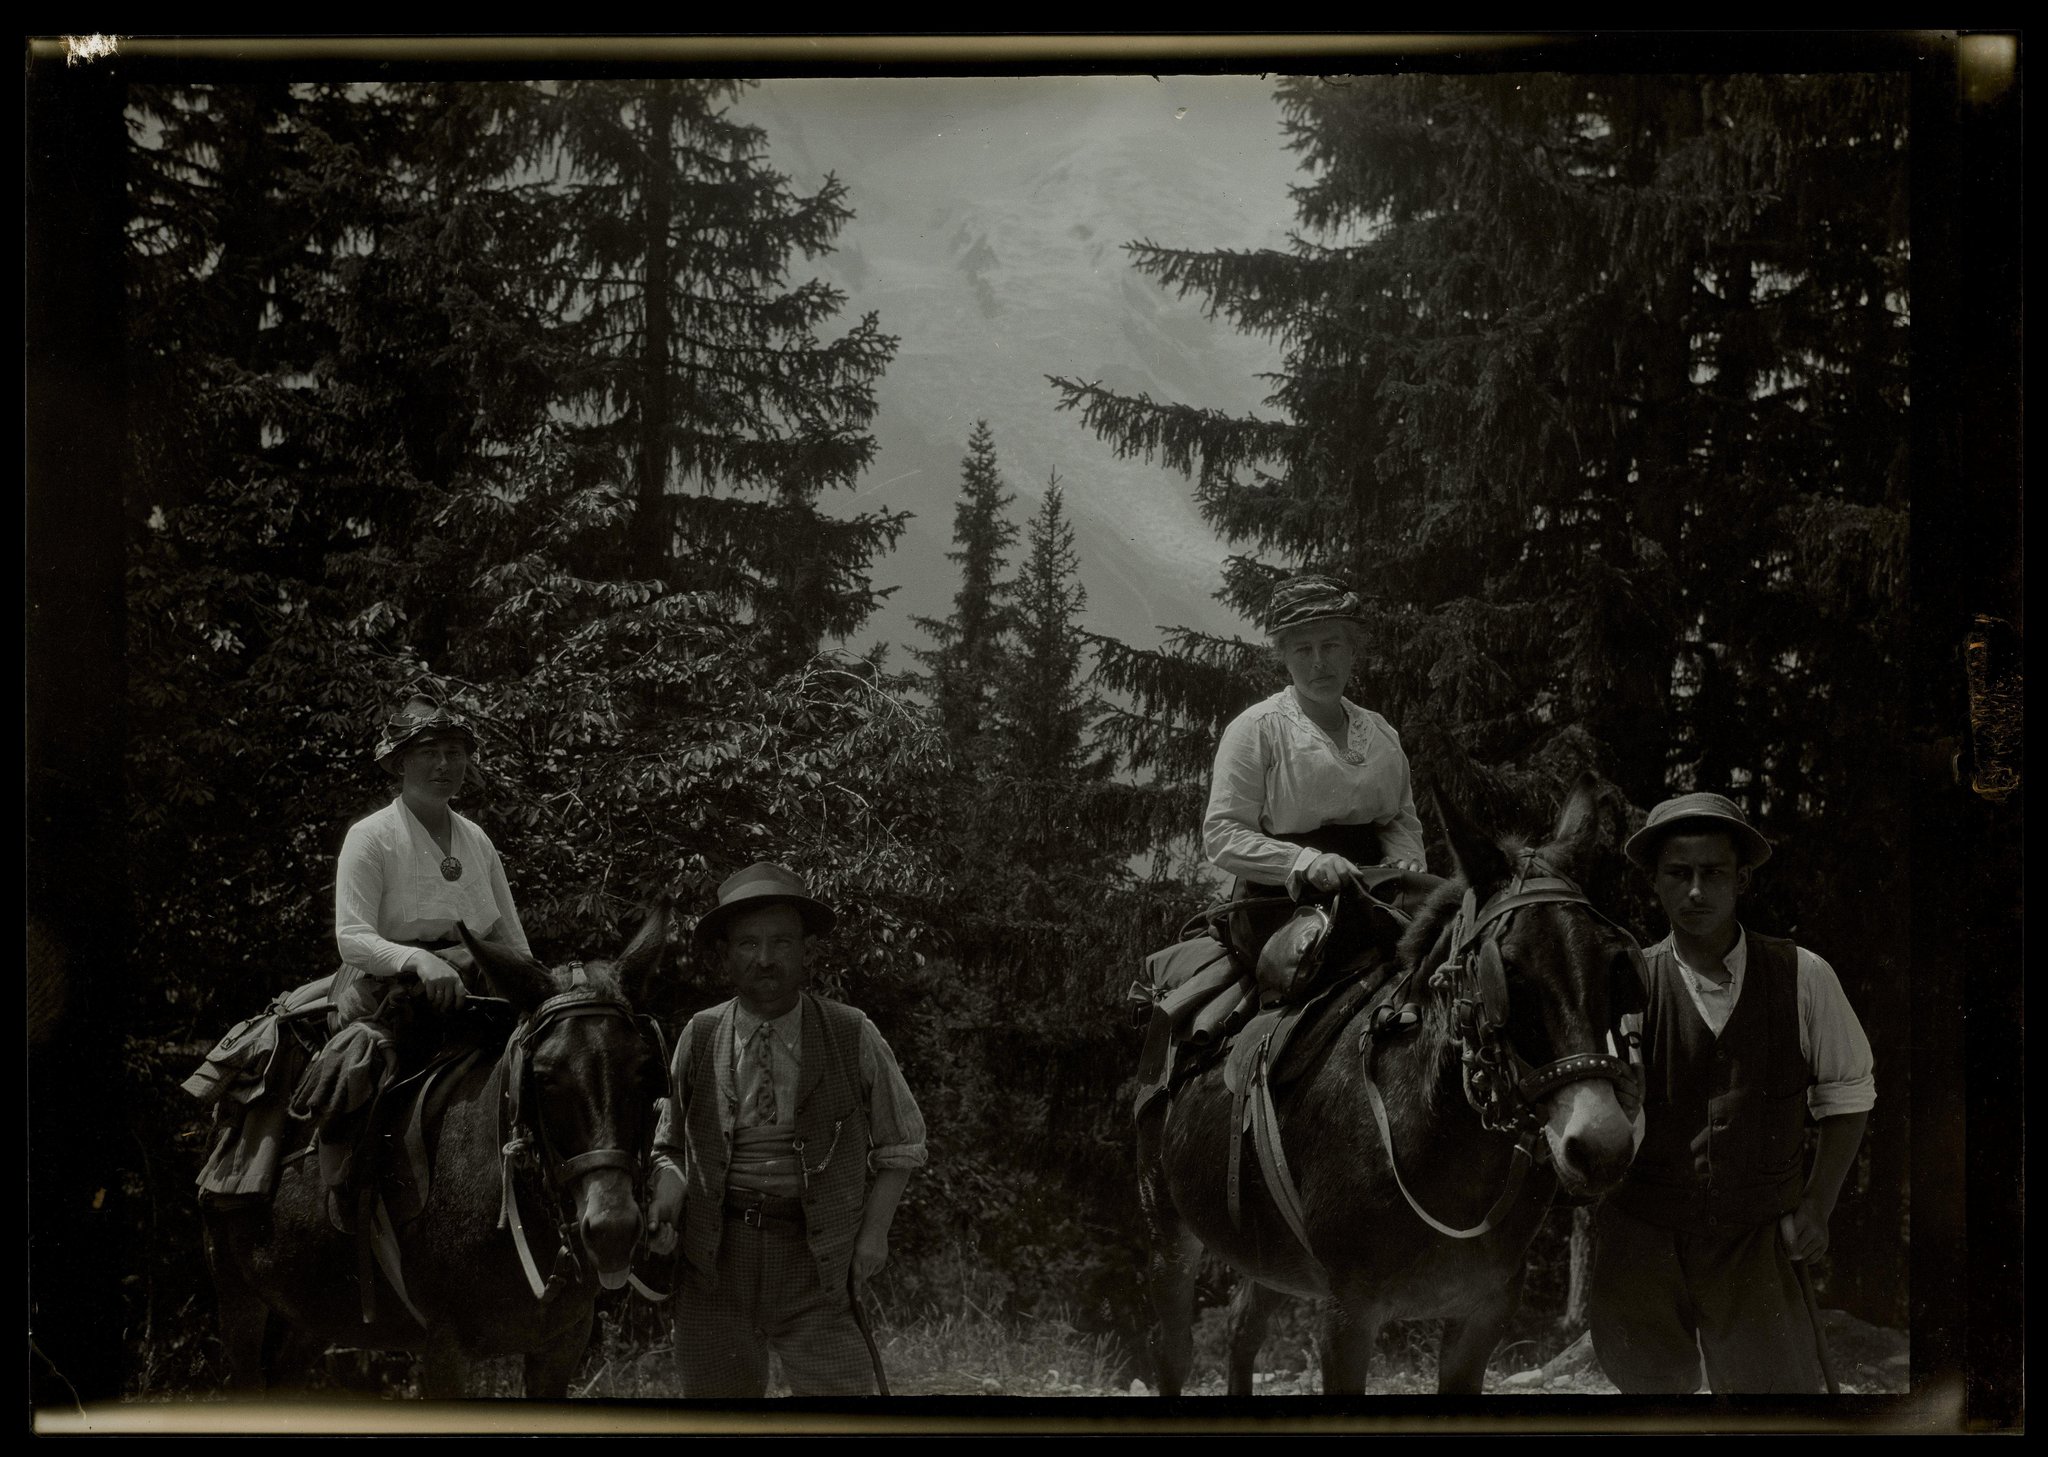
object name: photograph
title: Filmnegatief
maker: Anonymous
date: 1907-1935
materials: film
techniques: gelatin silver negative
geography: europe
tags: europe